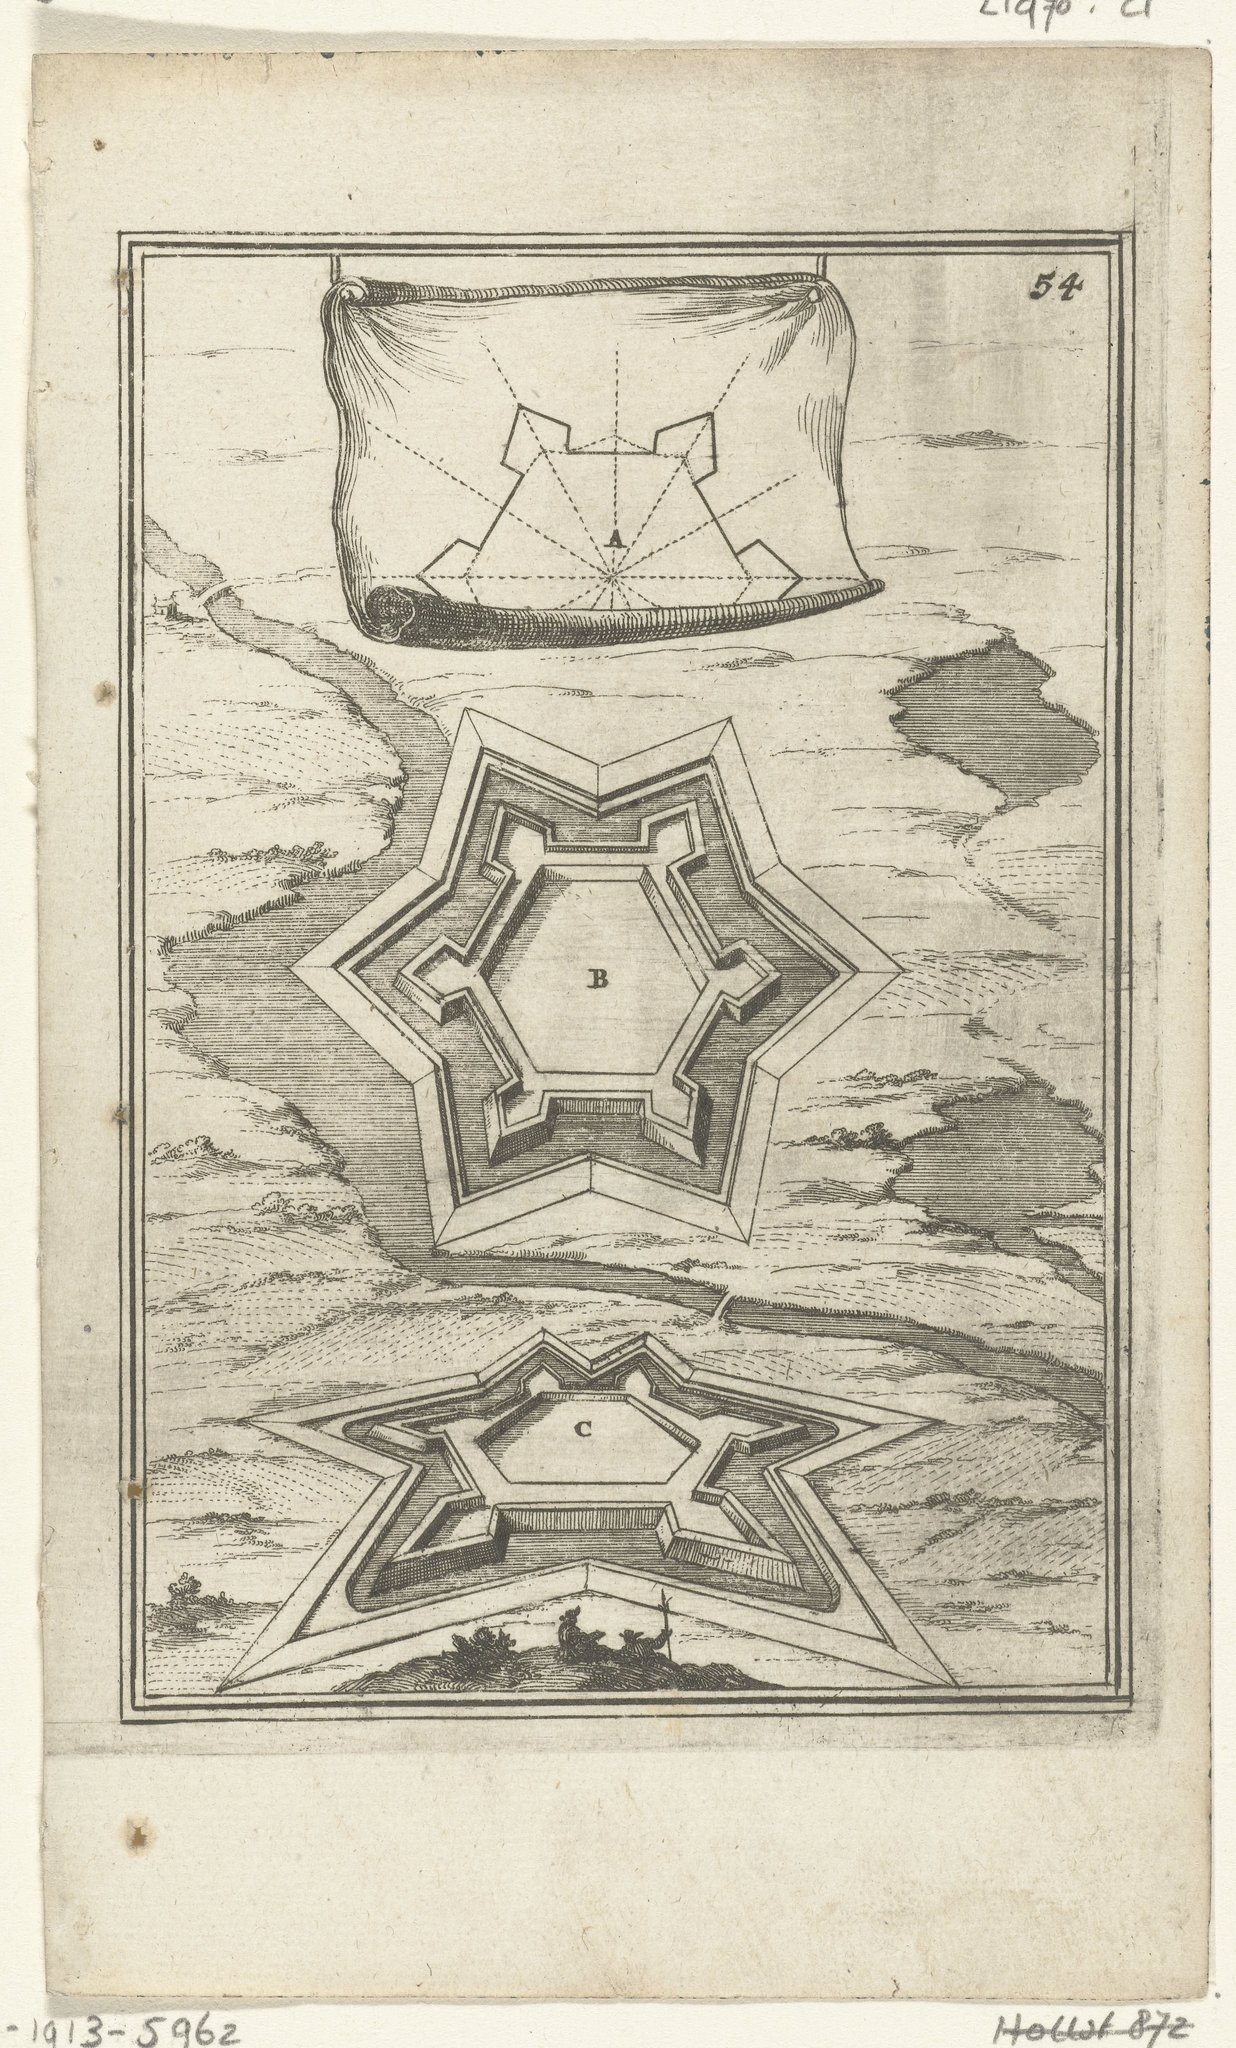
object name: book illustration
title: Illustratie voor 'Den Arbeid van Mars' van Allain Manesson Mallet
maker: romeyn de hooghe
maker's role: draughtsman, goldsmith, painter, print maker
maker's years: 1645-1708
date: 1672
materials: paper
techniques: etching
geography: amsterdam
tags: river, landscape with other man-made constructions not mentioned above, e.g.: graveyards, playgrounds, etc., fortifications, military engineering, mathematics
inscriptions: collector's mark: Lugt 2228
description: Grondplan voor een vesting, fort of versterking (zeshoek), driemaal onder elkaar afgebeeld: op een kaart, van bovenaf gezien in een landschap en in vogelvluchtperspectief in een landschap. In de hoek rechtsboven het cijfer 54 (= het nummer van de pagina in het boek waartegenover de illustratie geplaatst is).